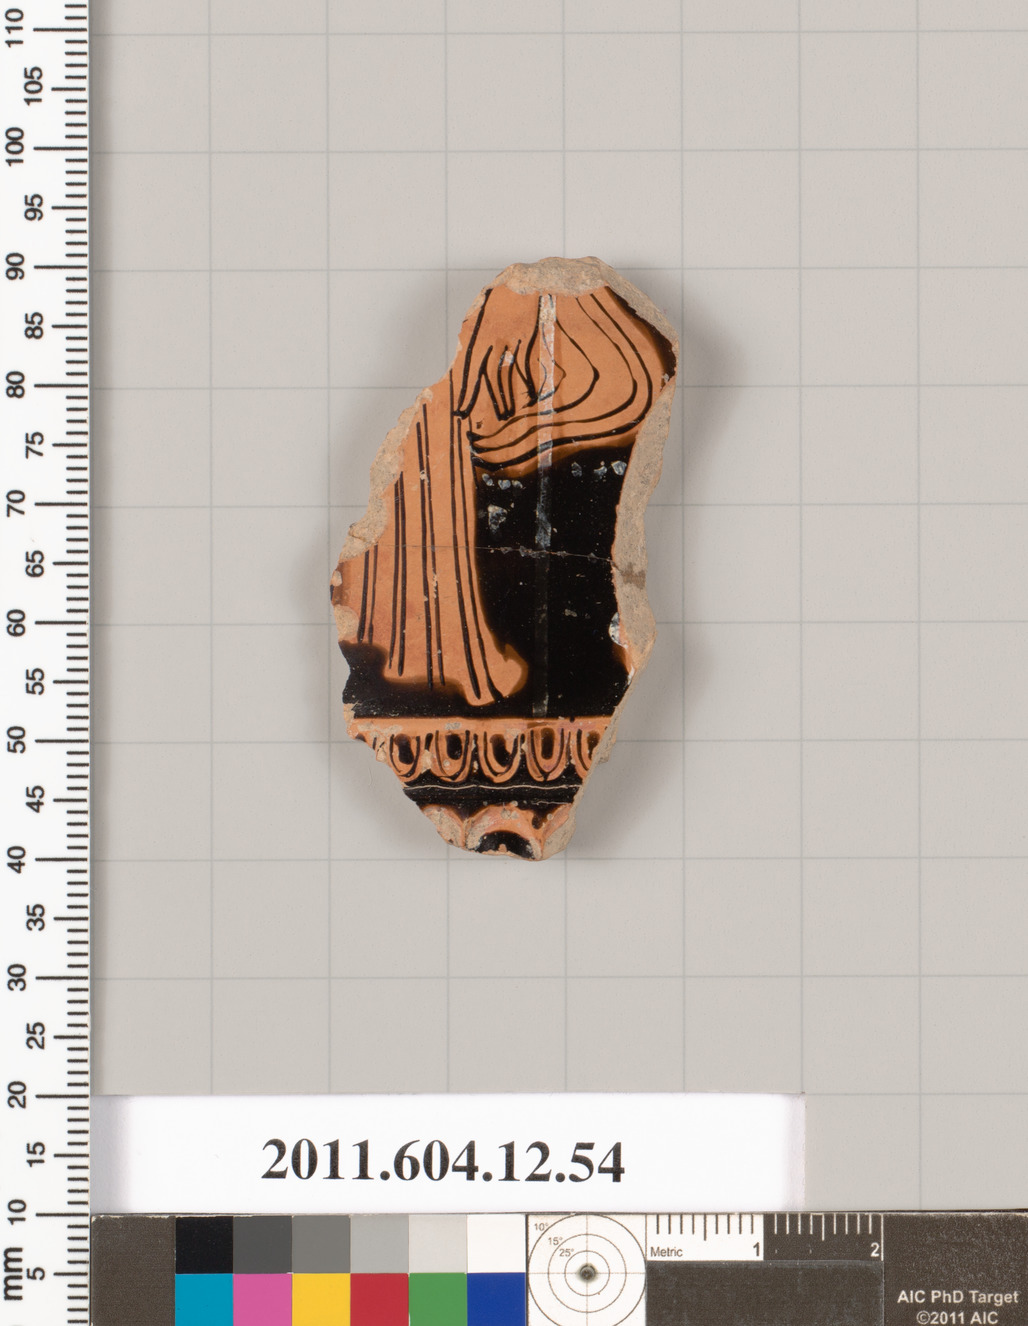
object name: undetermined closed shape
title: Terracotta fragment of a closed shape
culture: greek or south italian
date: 400-301 BCE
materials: terracotta